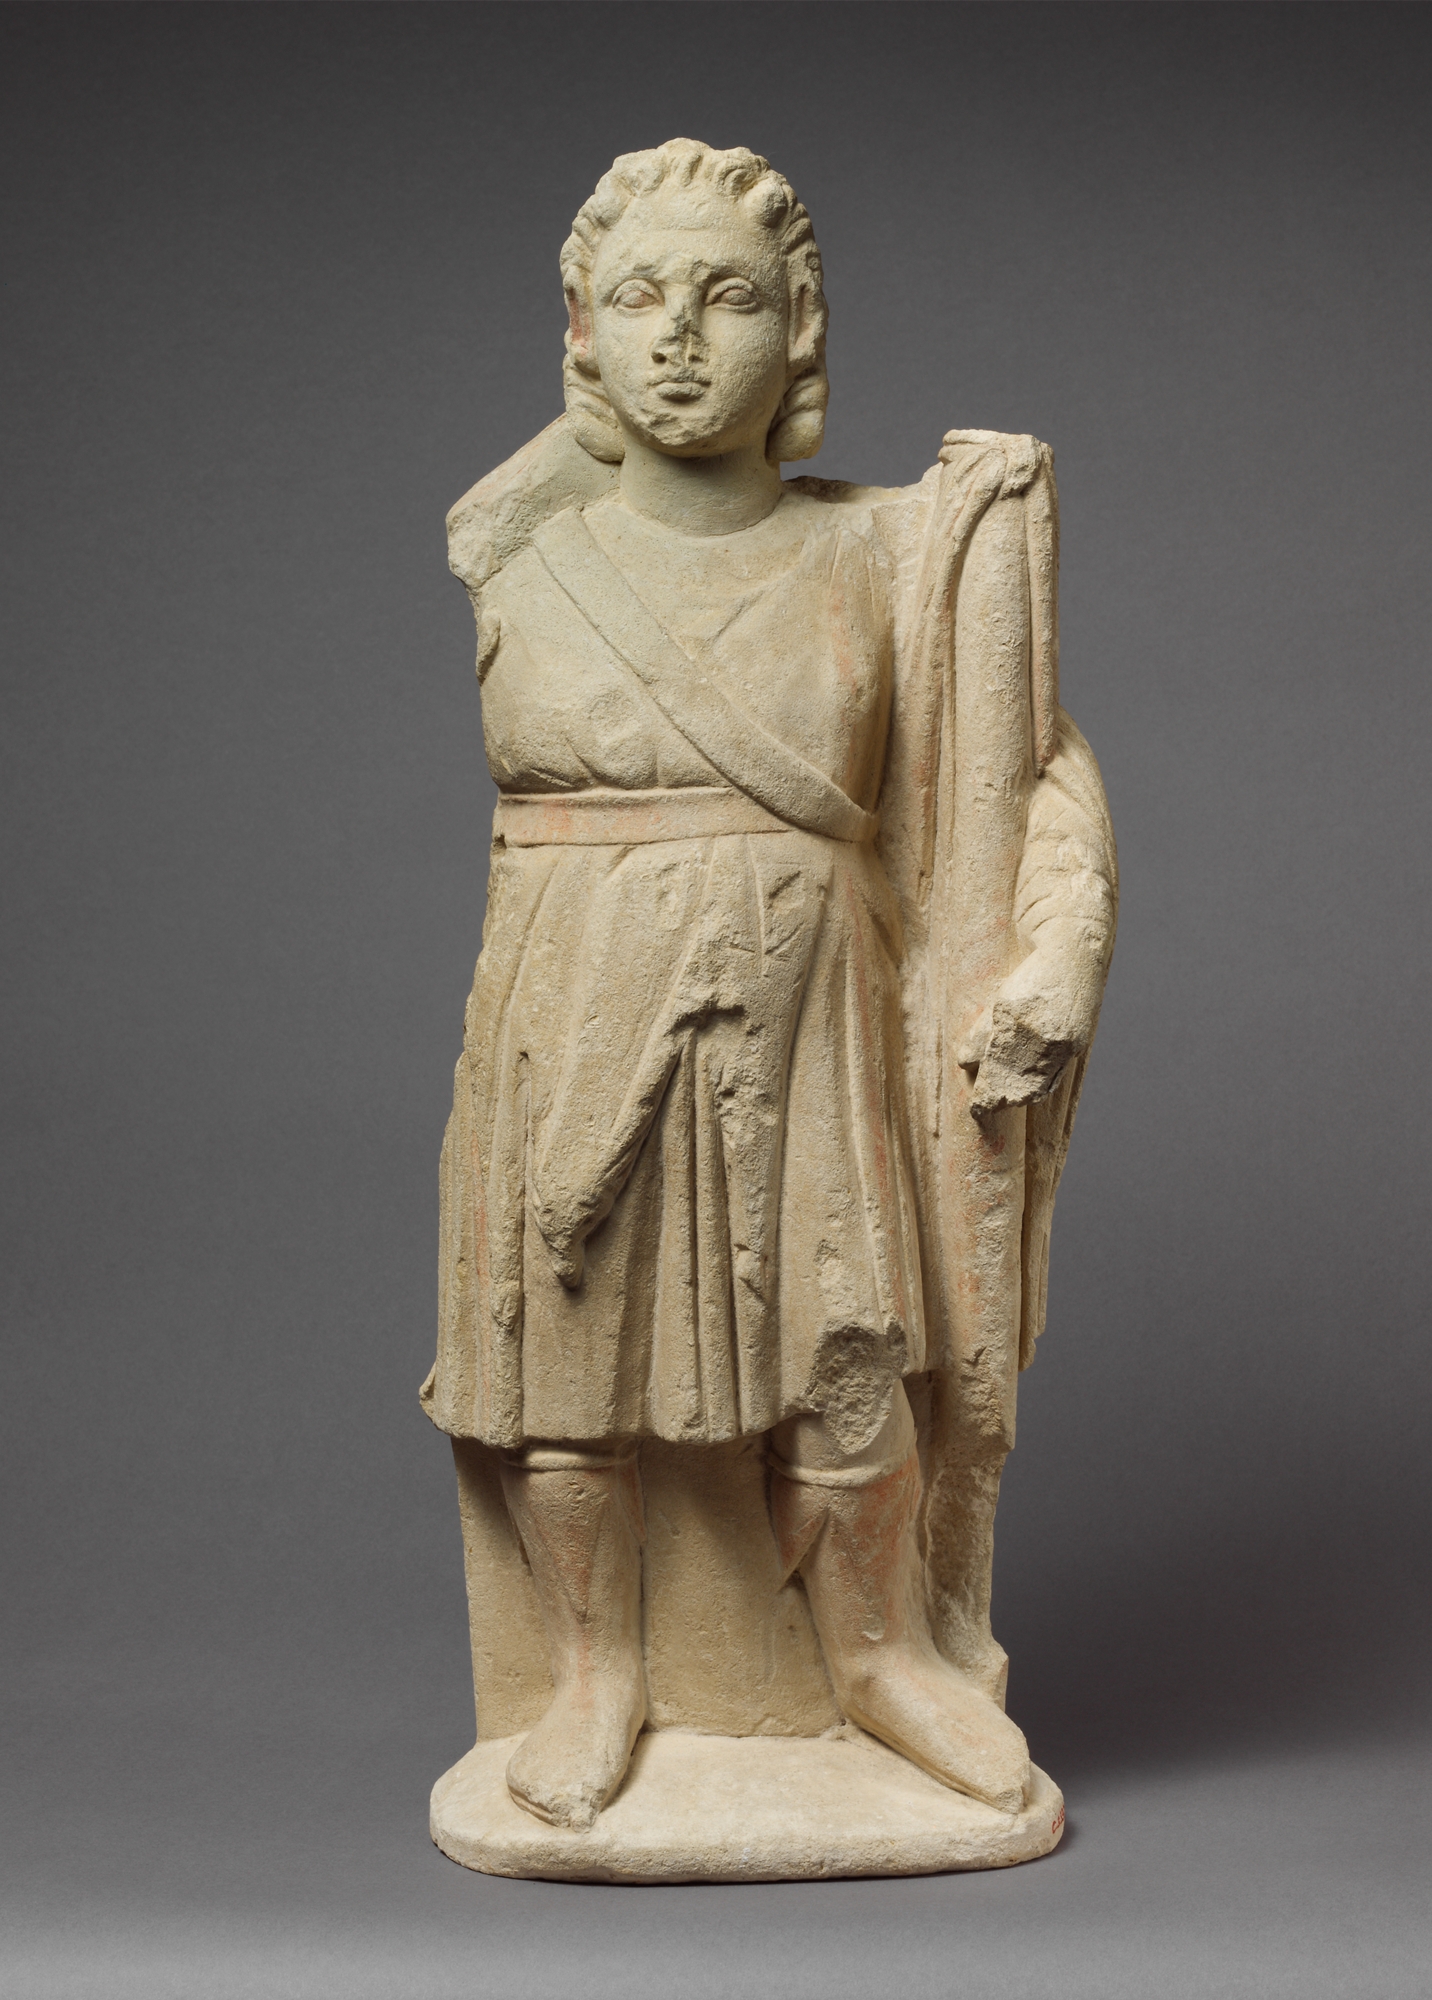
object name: statuette of dionysos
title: Limestone statuette of Dionysos holding a thyrsos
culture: cypriot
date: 310-30 BCE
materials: limestone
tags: dionysus